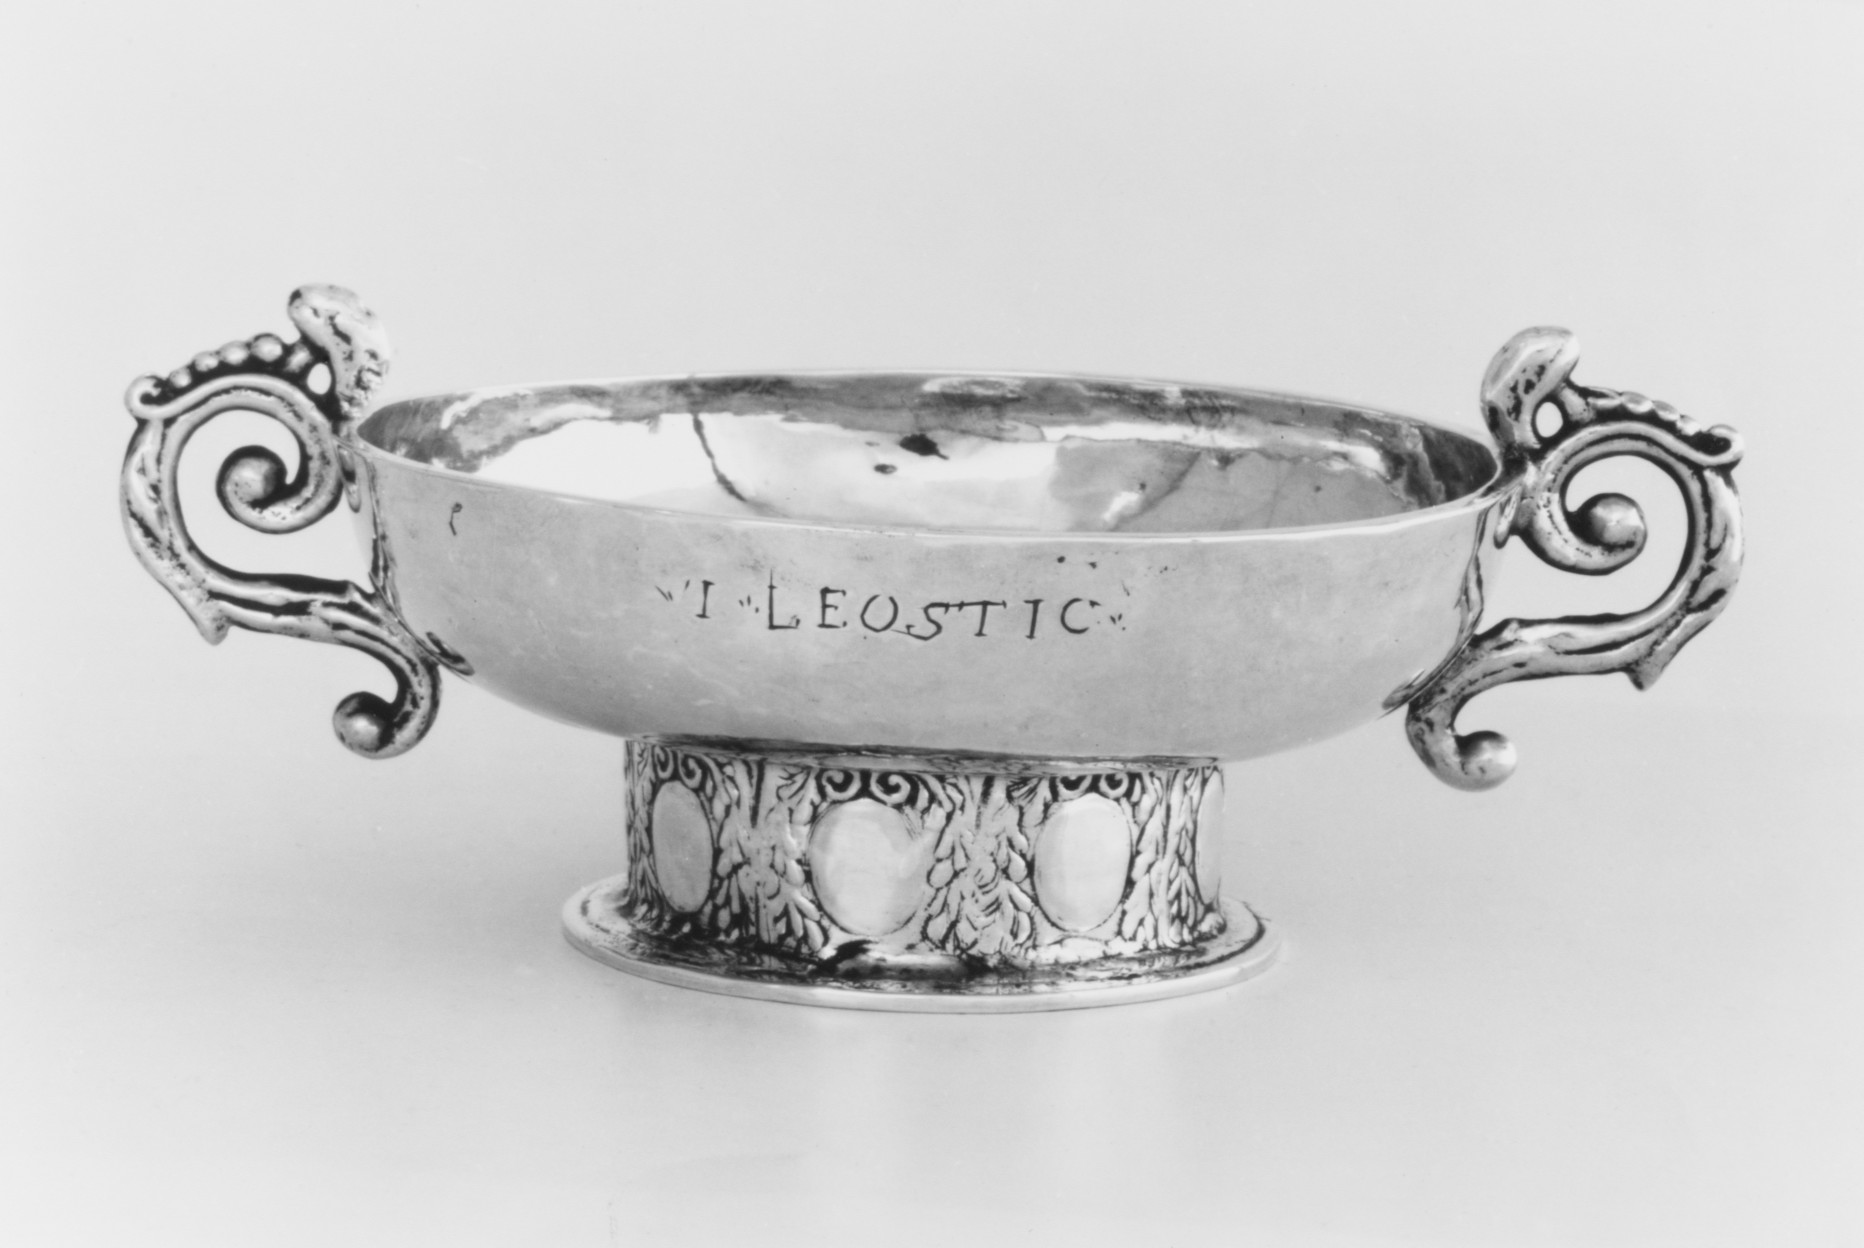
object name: collection cup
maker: anne maillard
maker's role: maker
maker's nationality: french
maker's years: 1723-1764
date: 1753-1758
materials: silver